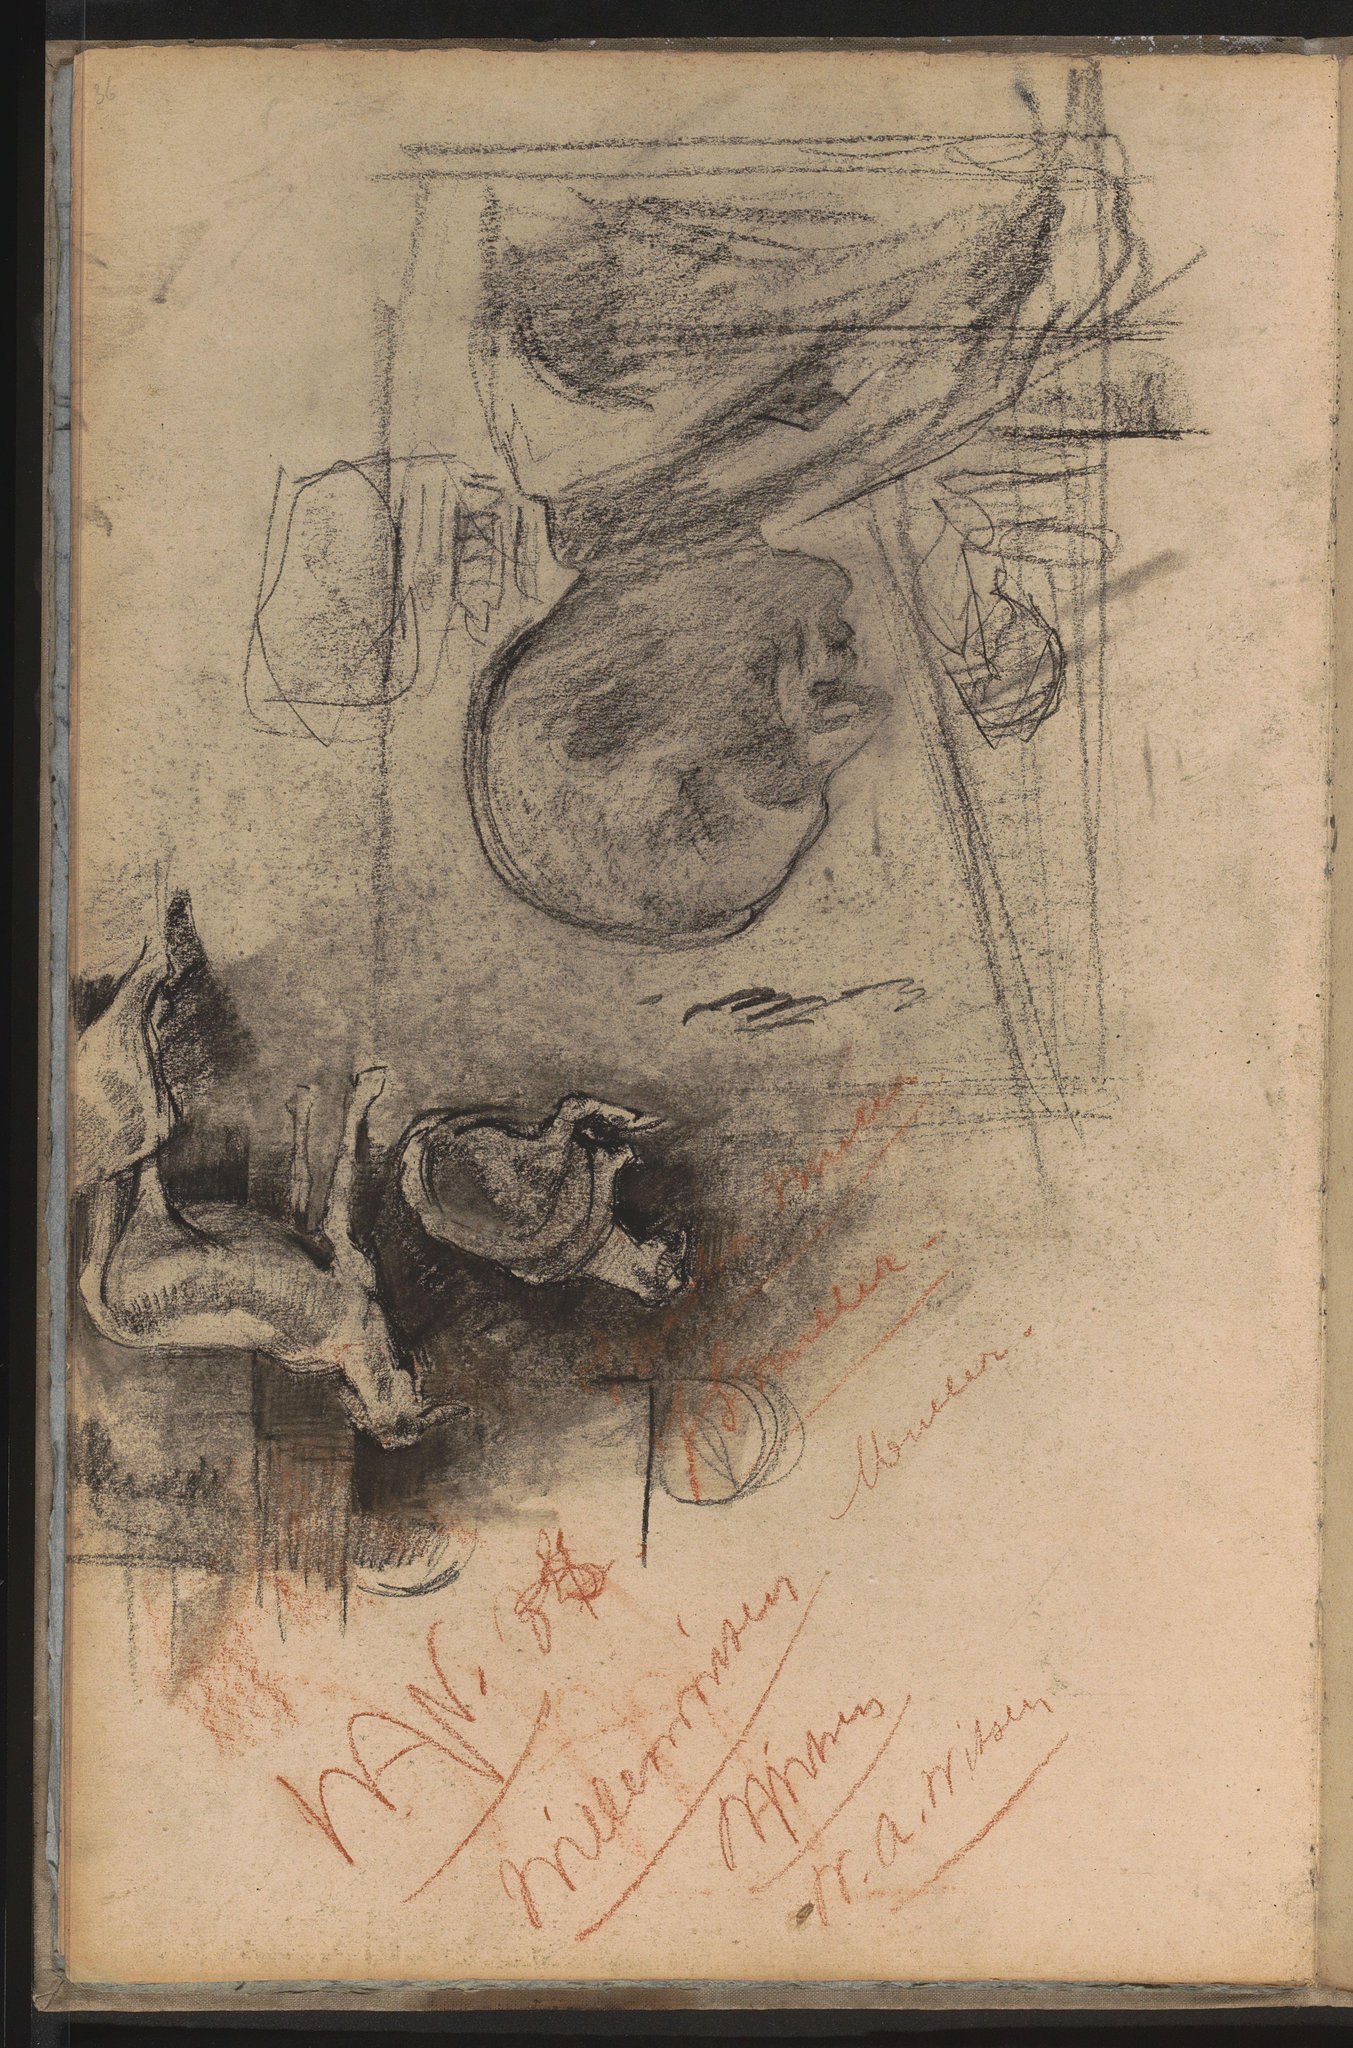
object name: sketchbook leaf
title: Schapen in een stal en een mannenbuste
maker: willem witsen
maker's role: draughtsman, painter, print maker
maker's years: 1860-1923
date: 1884-1887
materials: chalk, paper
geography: ewijkshoeve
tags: head (human) (+ sideview, profile), sheep, stall, stable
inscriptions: signature: ‘WW/ [...]/ Willemwitsen/ WWitsen/ W.A. Witsen’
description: Pagina 36 uit een schetsboek met 45 bladen vervaardigd rond de Ewijkshoeve.